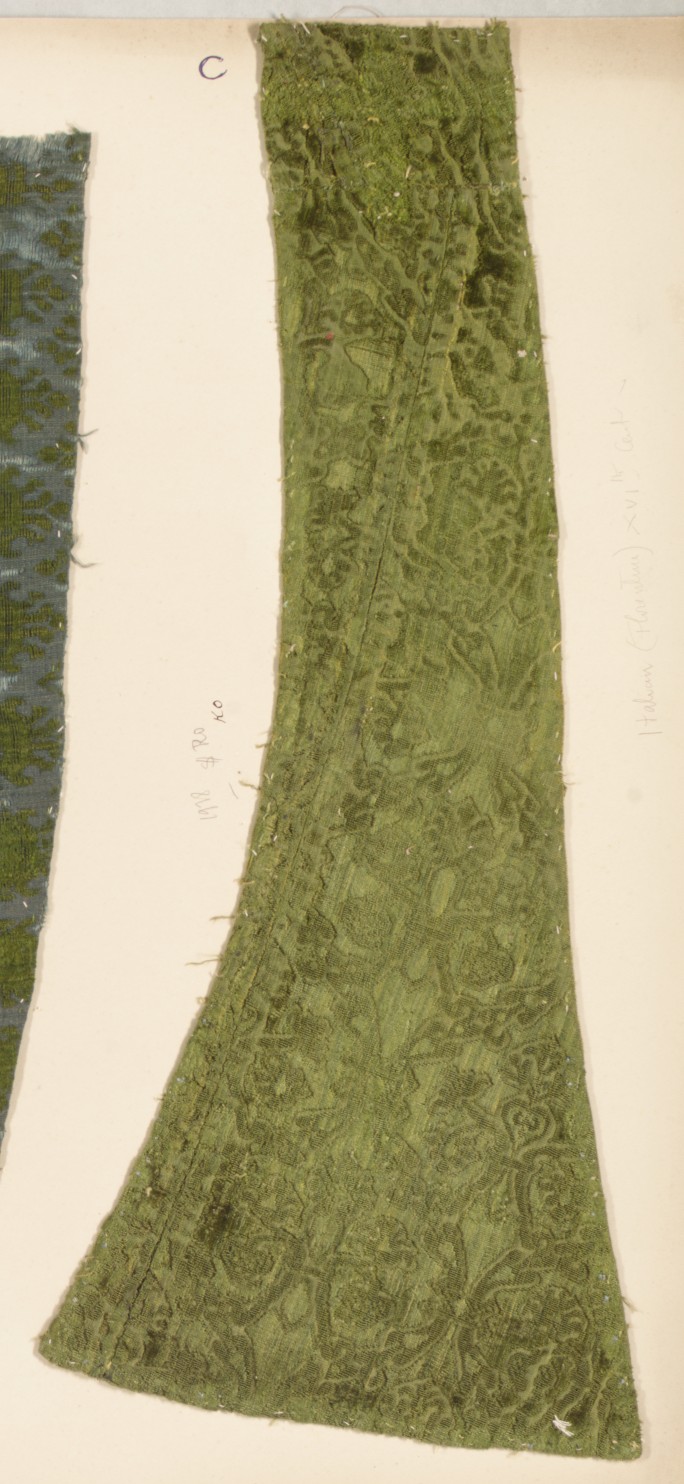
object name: fragment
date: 1501-1600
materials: silk